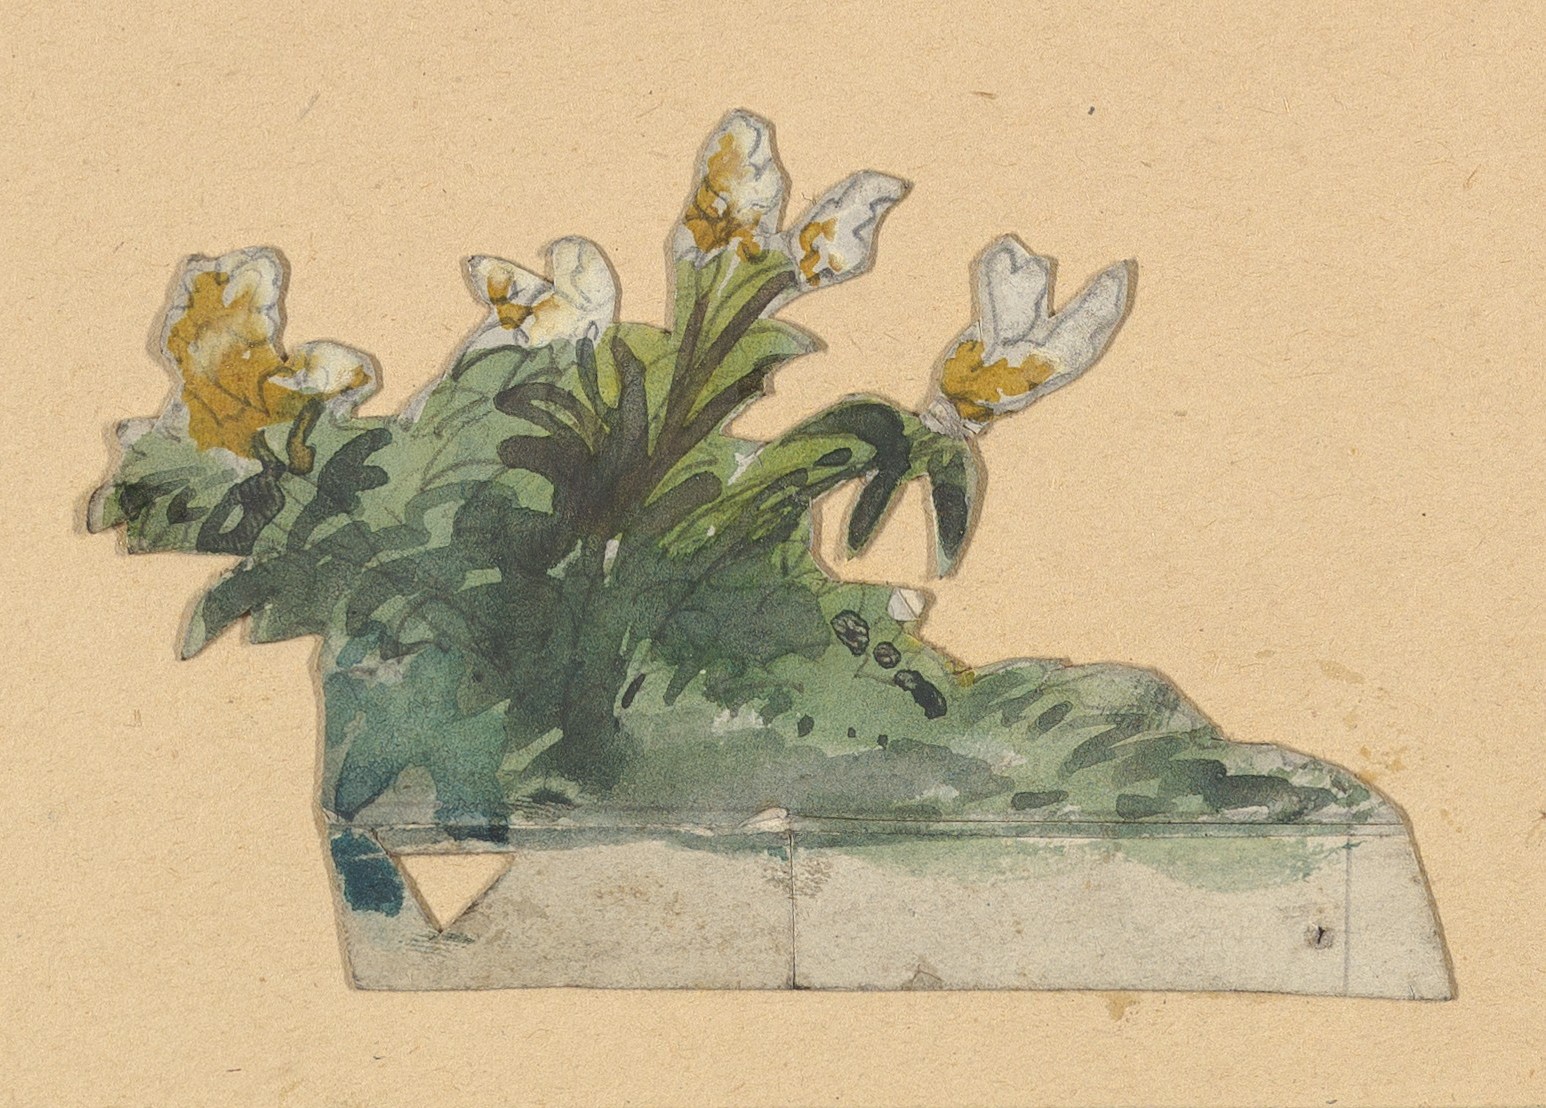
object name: drawing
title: Design for a Stage Set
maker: eugène cicéri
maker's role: artist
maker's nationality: french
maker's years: 1813-1890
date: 1830-1890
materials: graphite, watercolor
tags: flowers,stage design